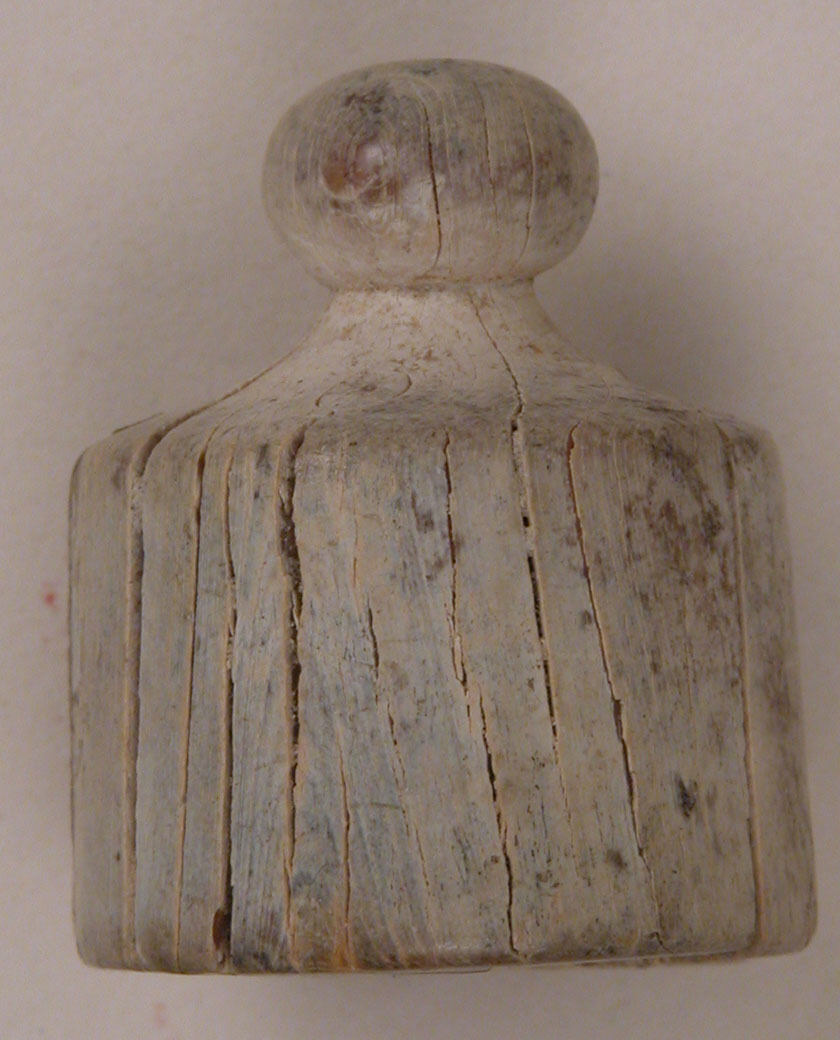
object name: chess piece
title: Chess Piece, Pawn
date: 701-1100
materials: ivory, wood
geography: iran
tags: chess